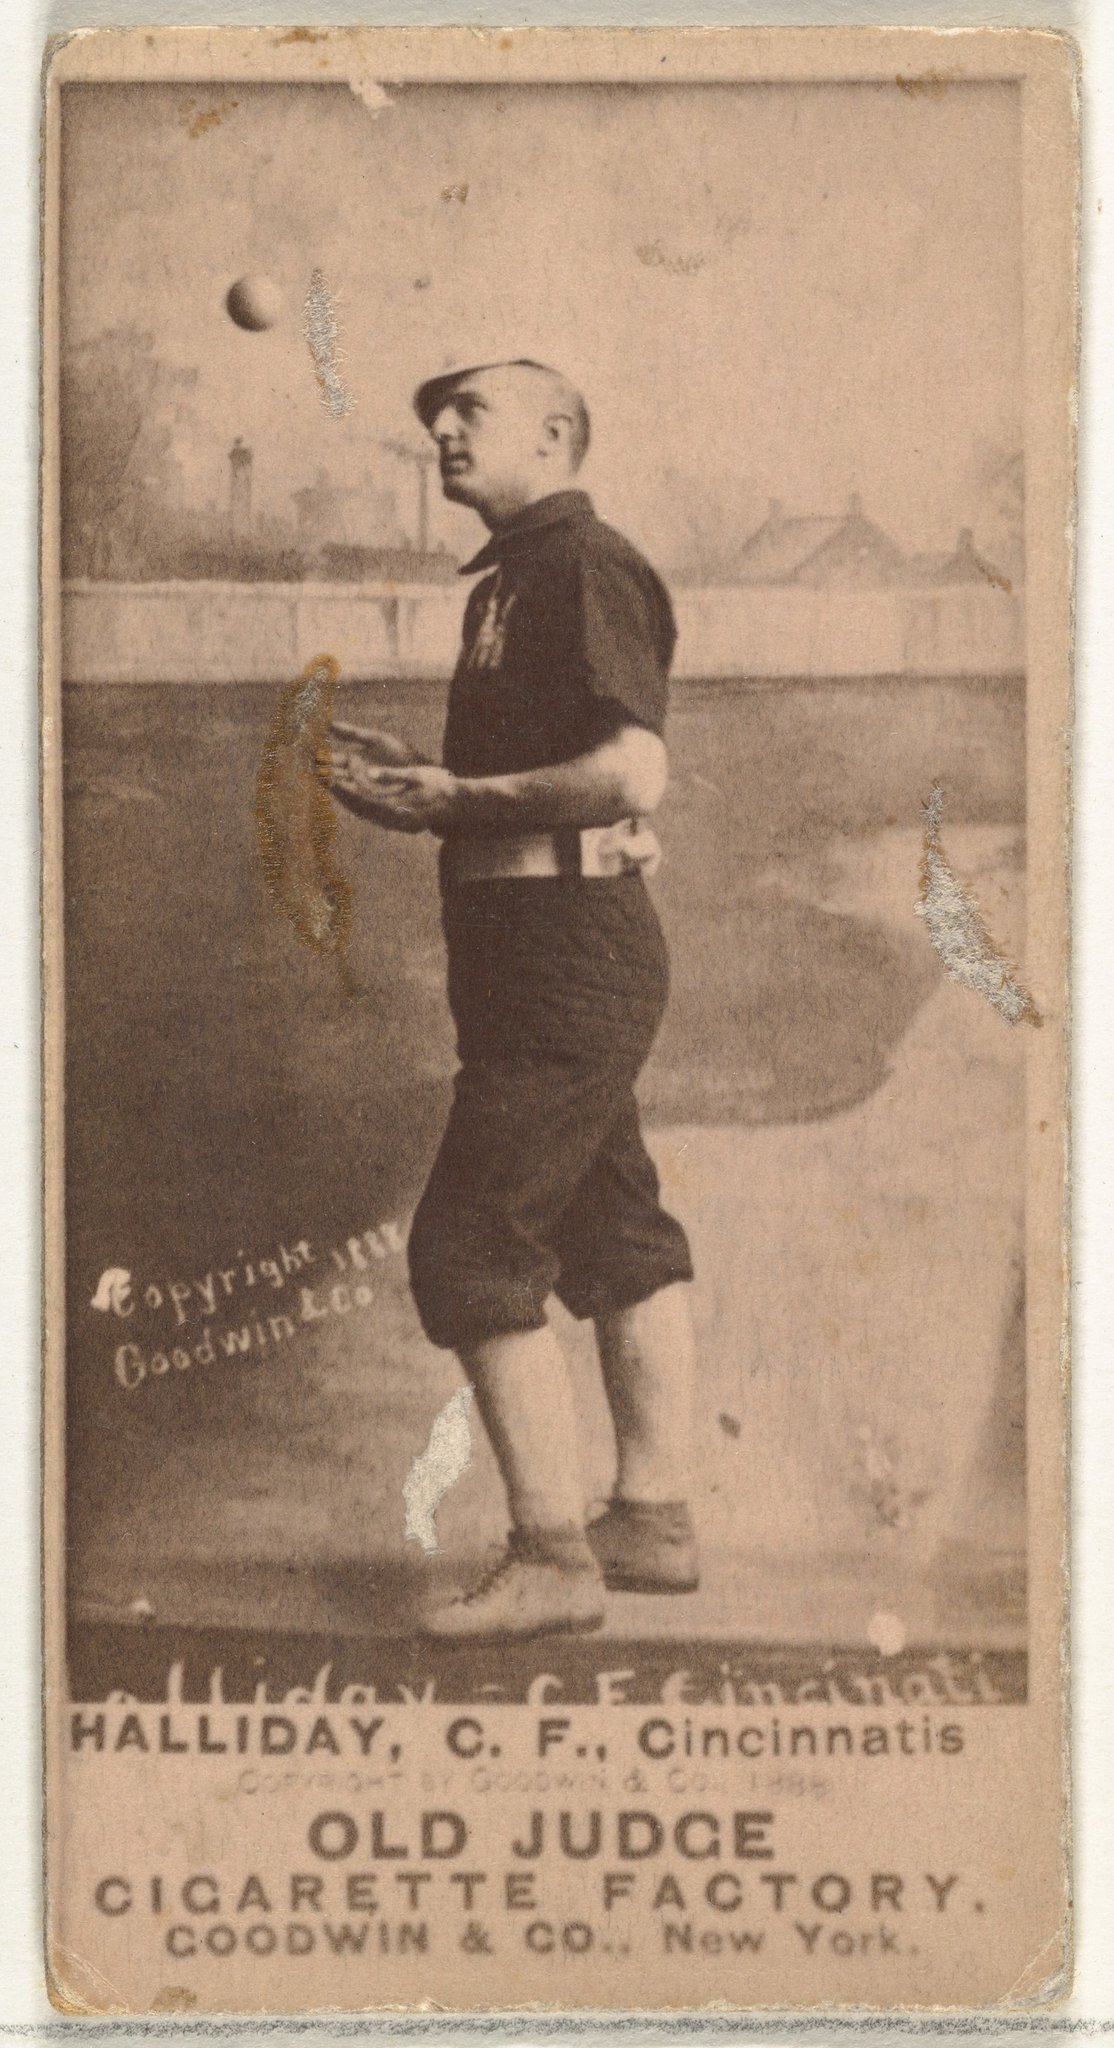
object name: baseball card, photograph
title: James Wear "Bug" Holliday, Center Field, Cincinnati, from the Old Judge series (N172) for Old Judge Cigarettes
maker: goodwin & company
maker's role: publisher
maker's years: 1850-1950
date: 1888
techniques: albumen silver print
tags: men,portraits,baseball,athletes